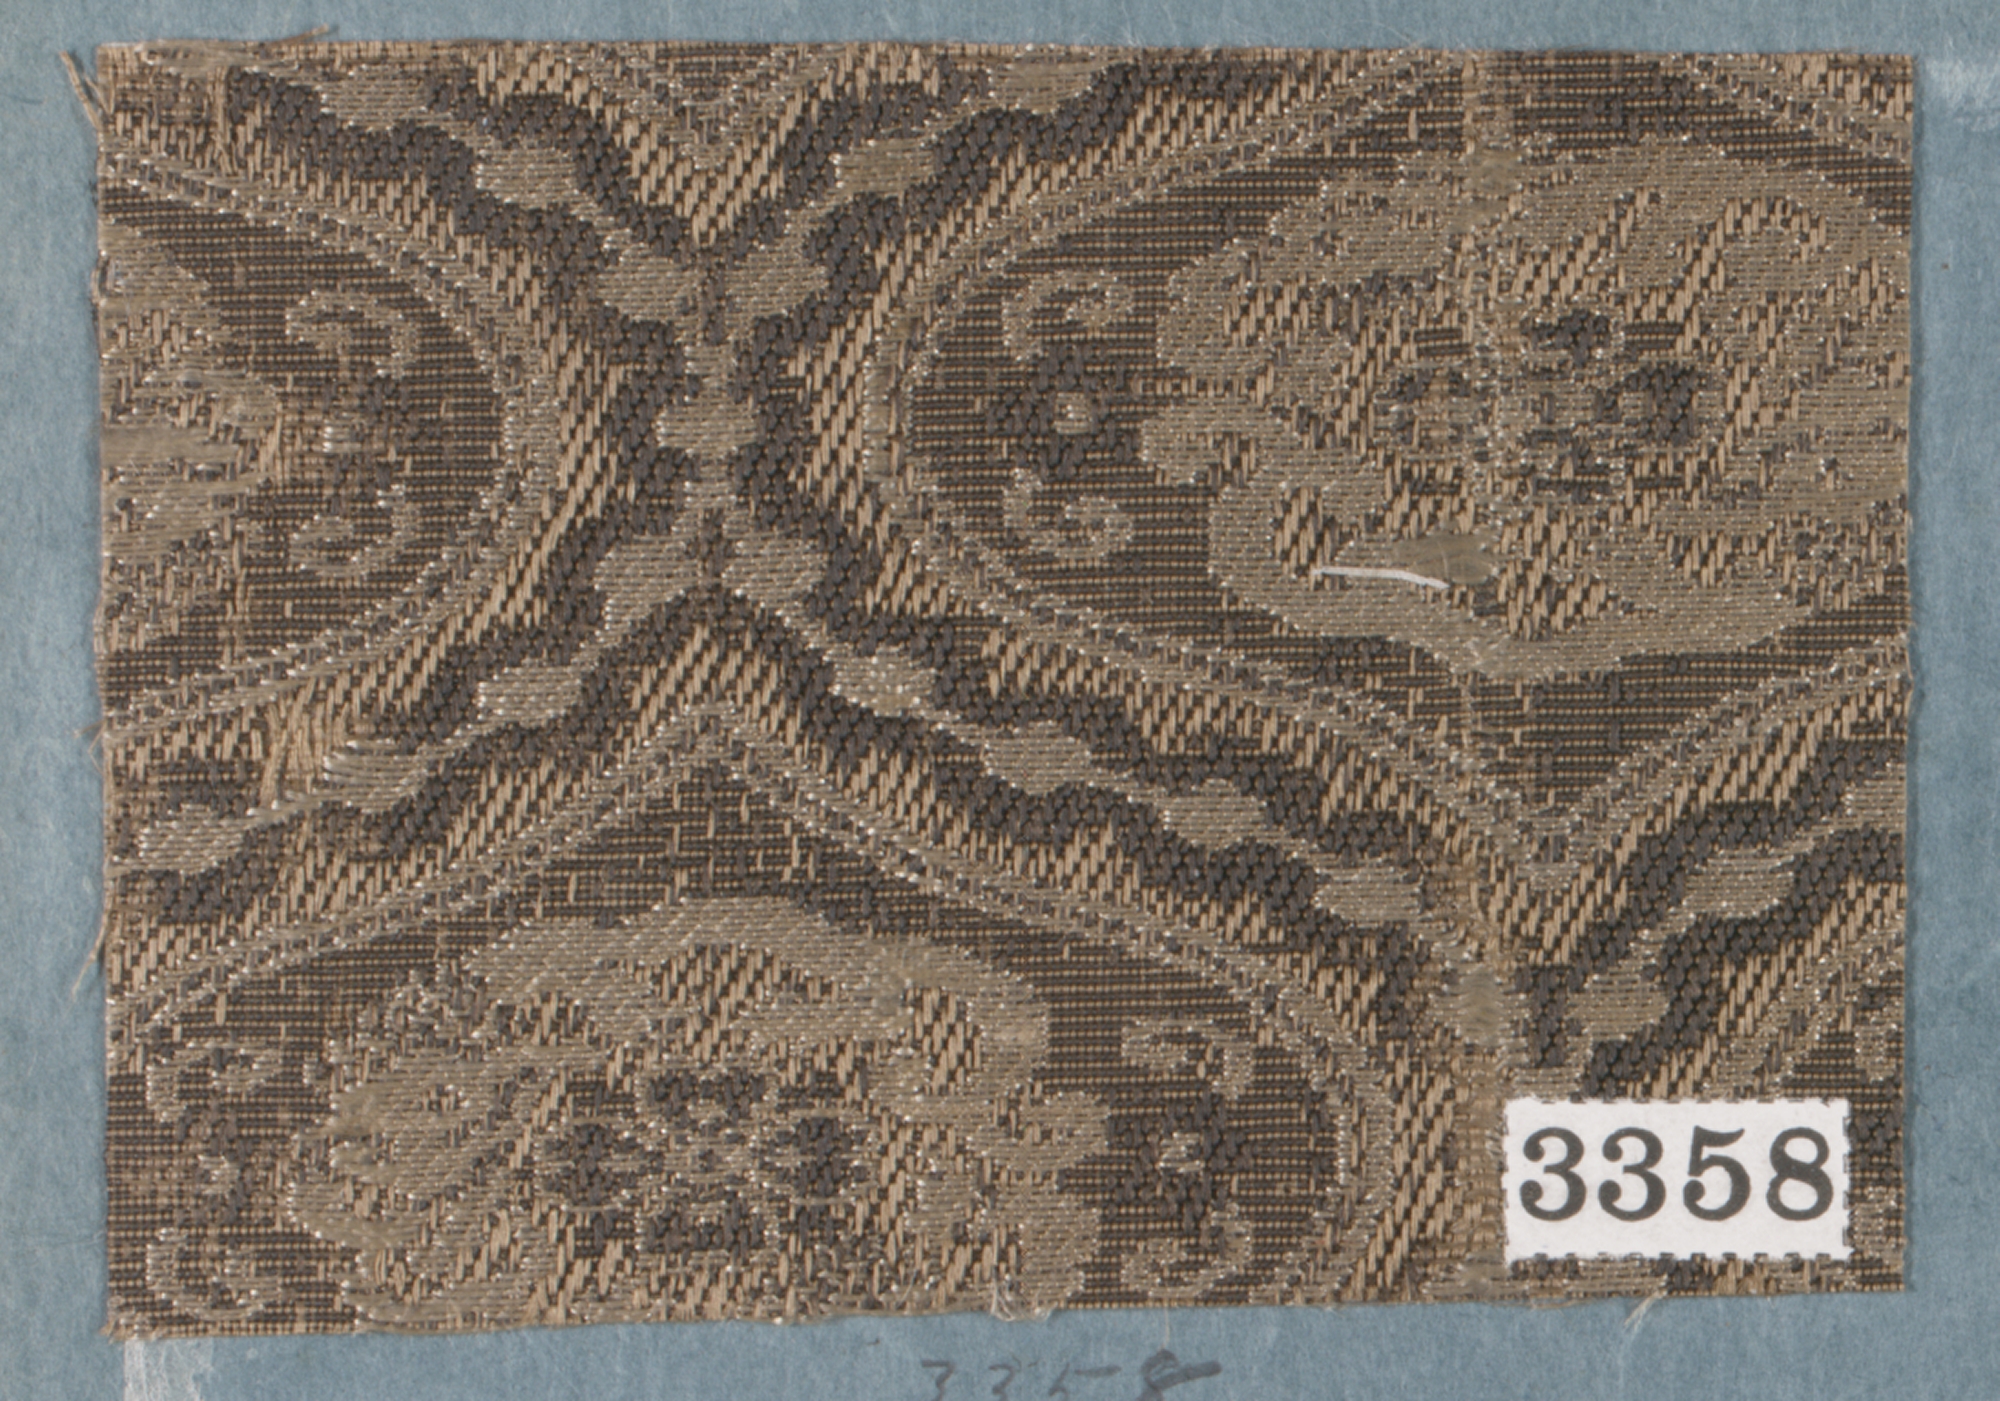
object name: textile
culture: japanese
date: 1801-1900